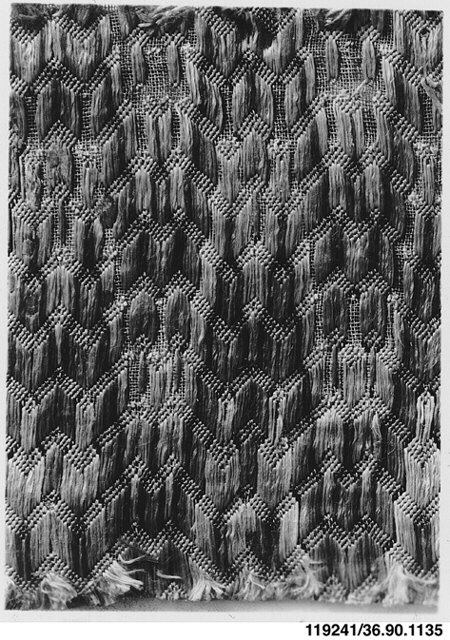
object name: piece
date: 1701-1800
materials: cotton, silk